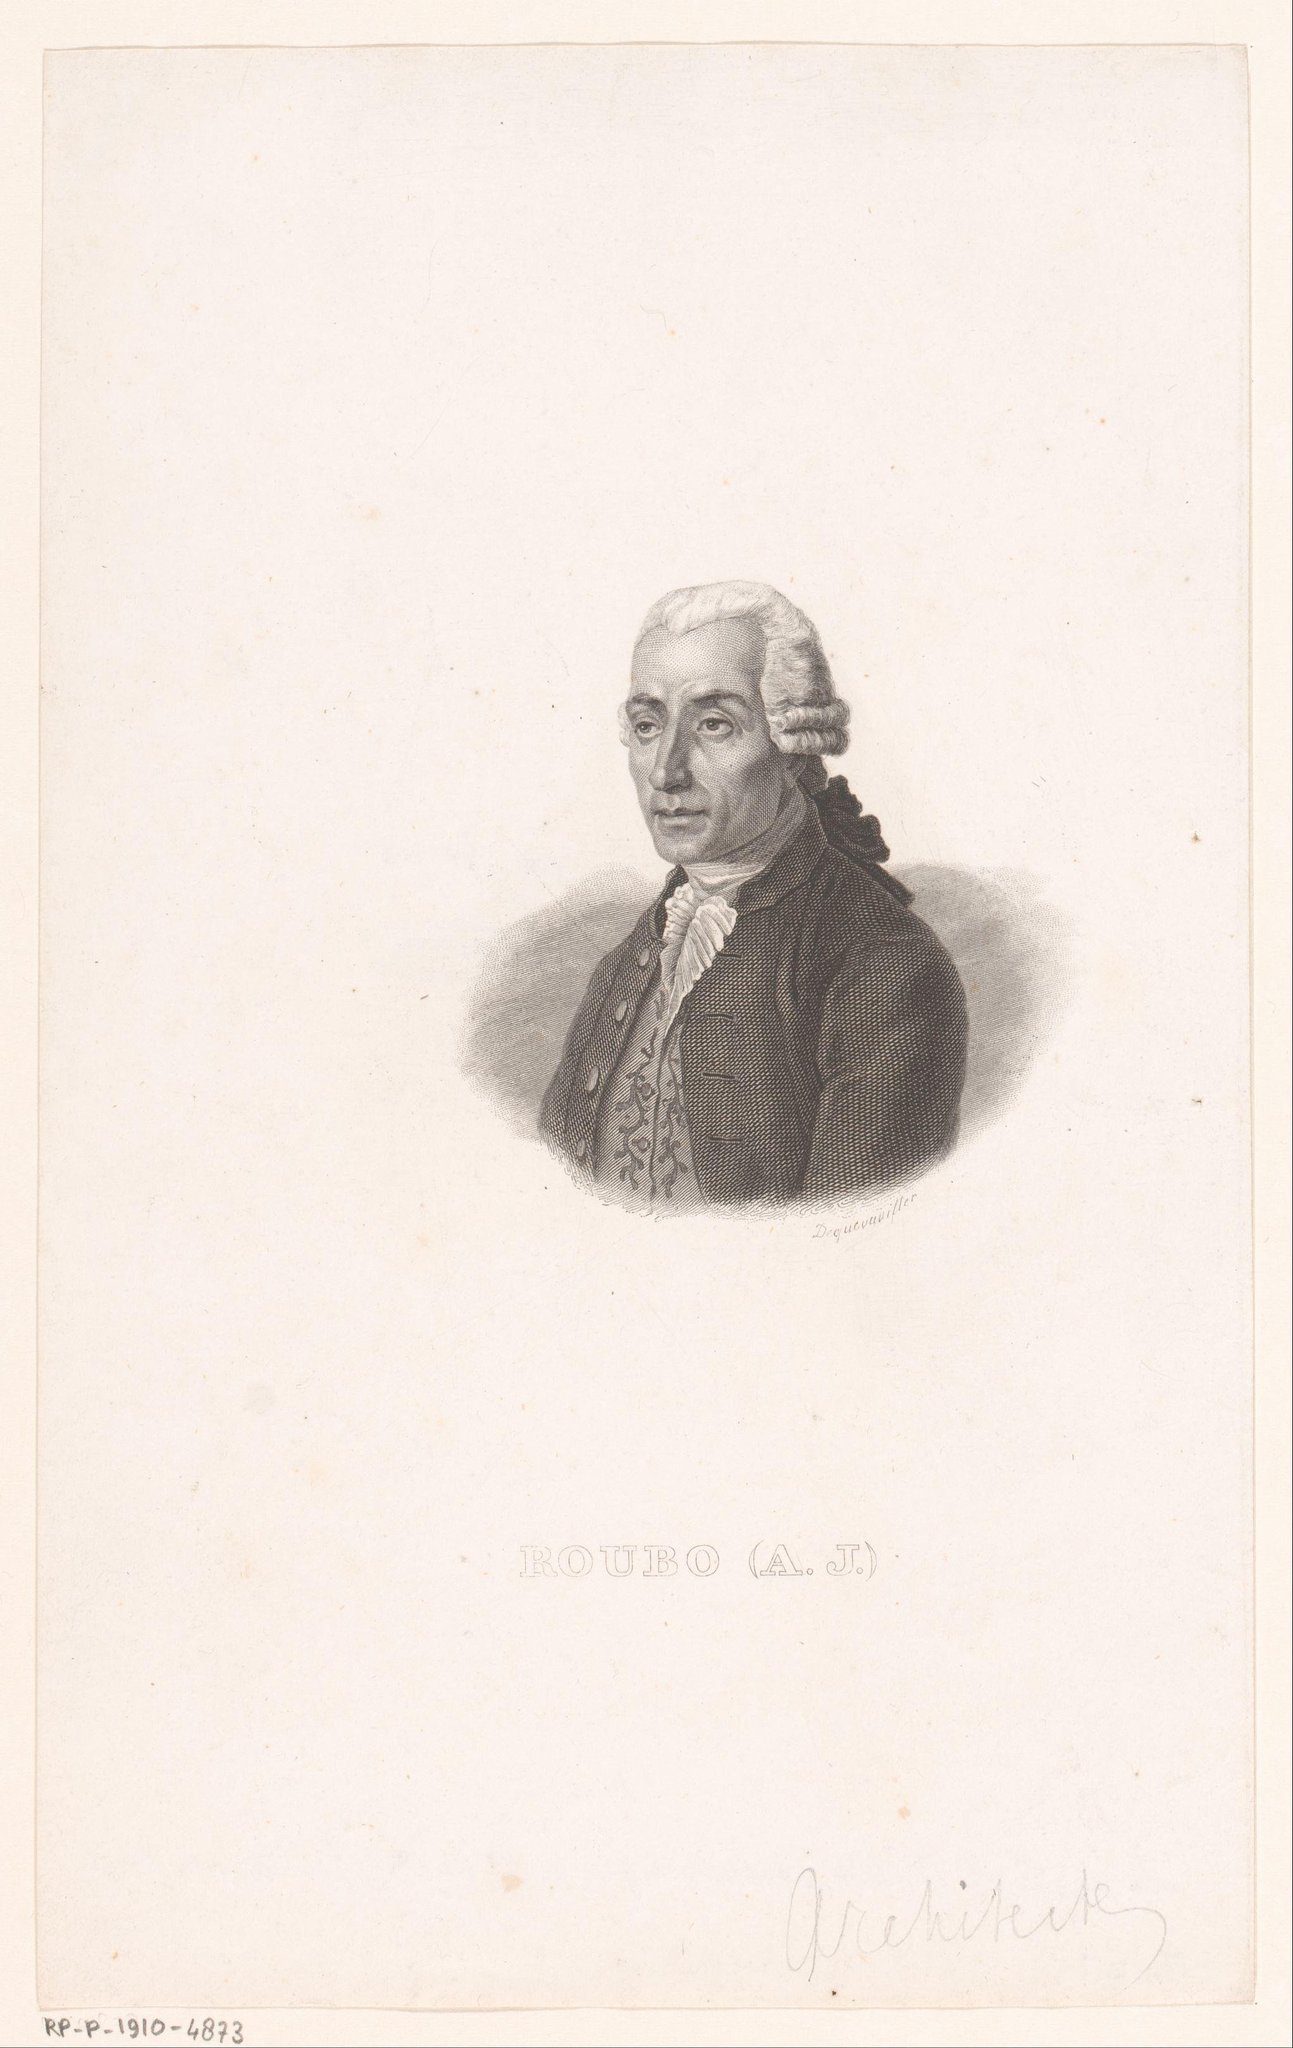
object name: print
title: Portret van André Jacob Roubo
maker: françois jacques dequevauviller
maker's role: print maker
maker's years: 1783-1848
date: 1793-1848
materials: paper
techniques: engraving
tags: paris, andré jacob roubo, joiner, cabinet maker, 'ébéniste', historical persons, portrait of a writer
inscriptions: collector's mark: Lugt 2228